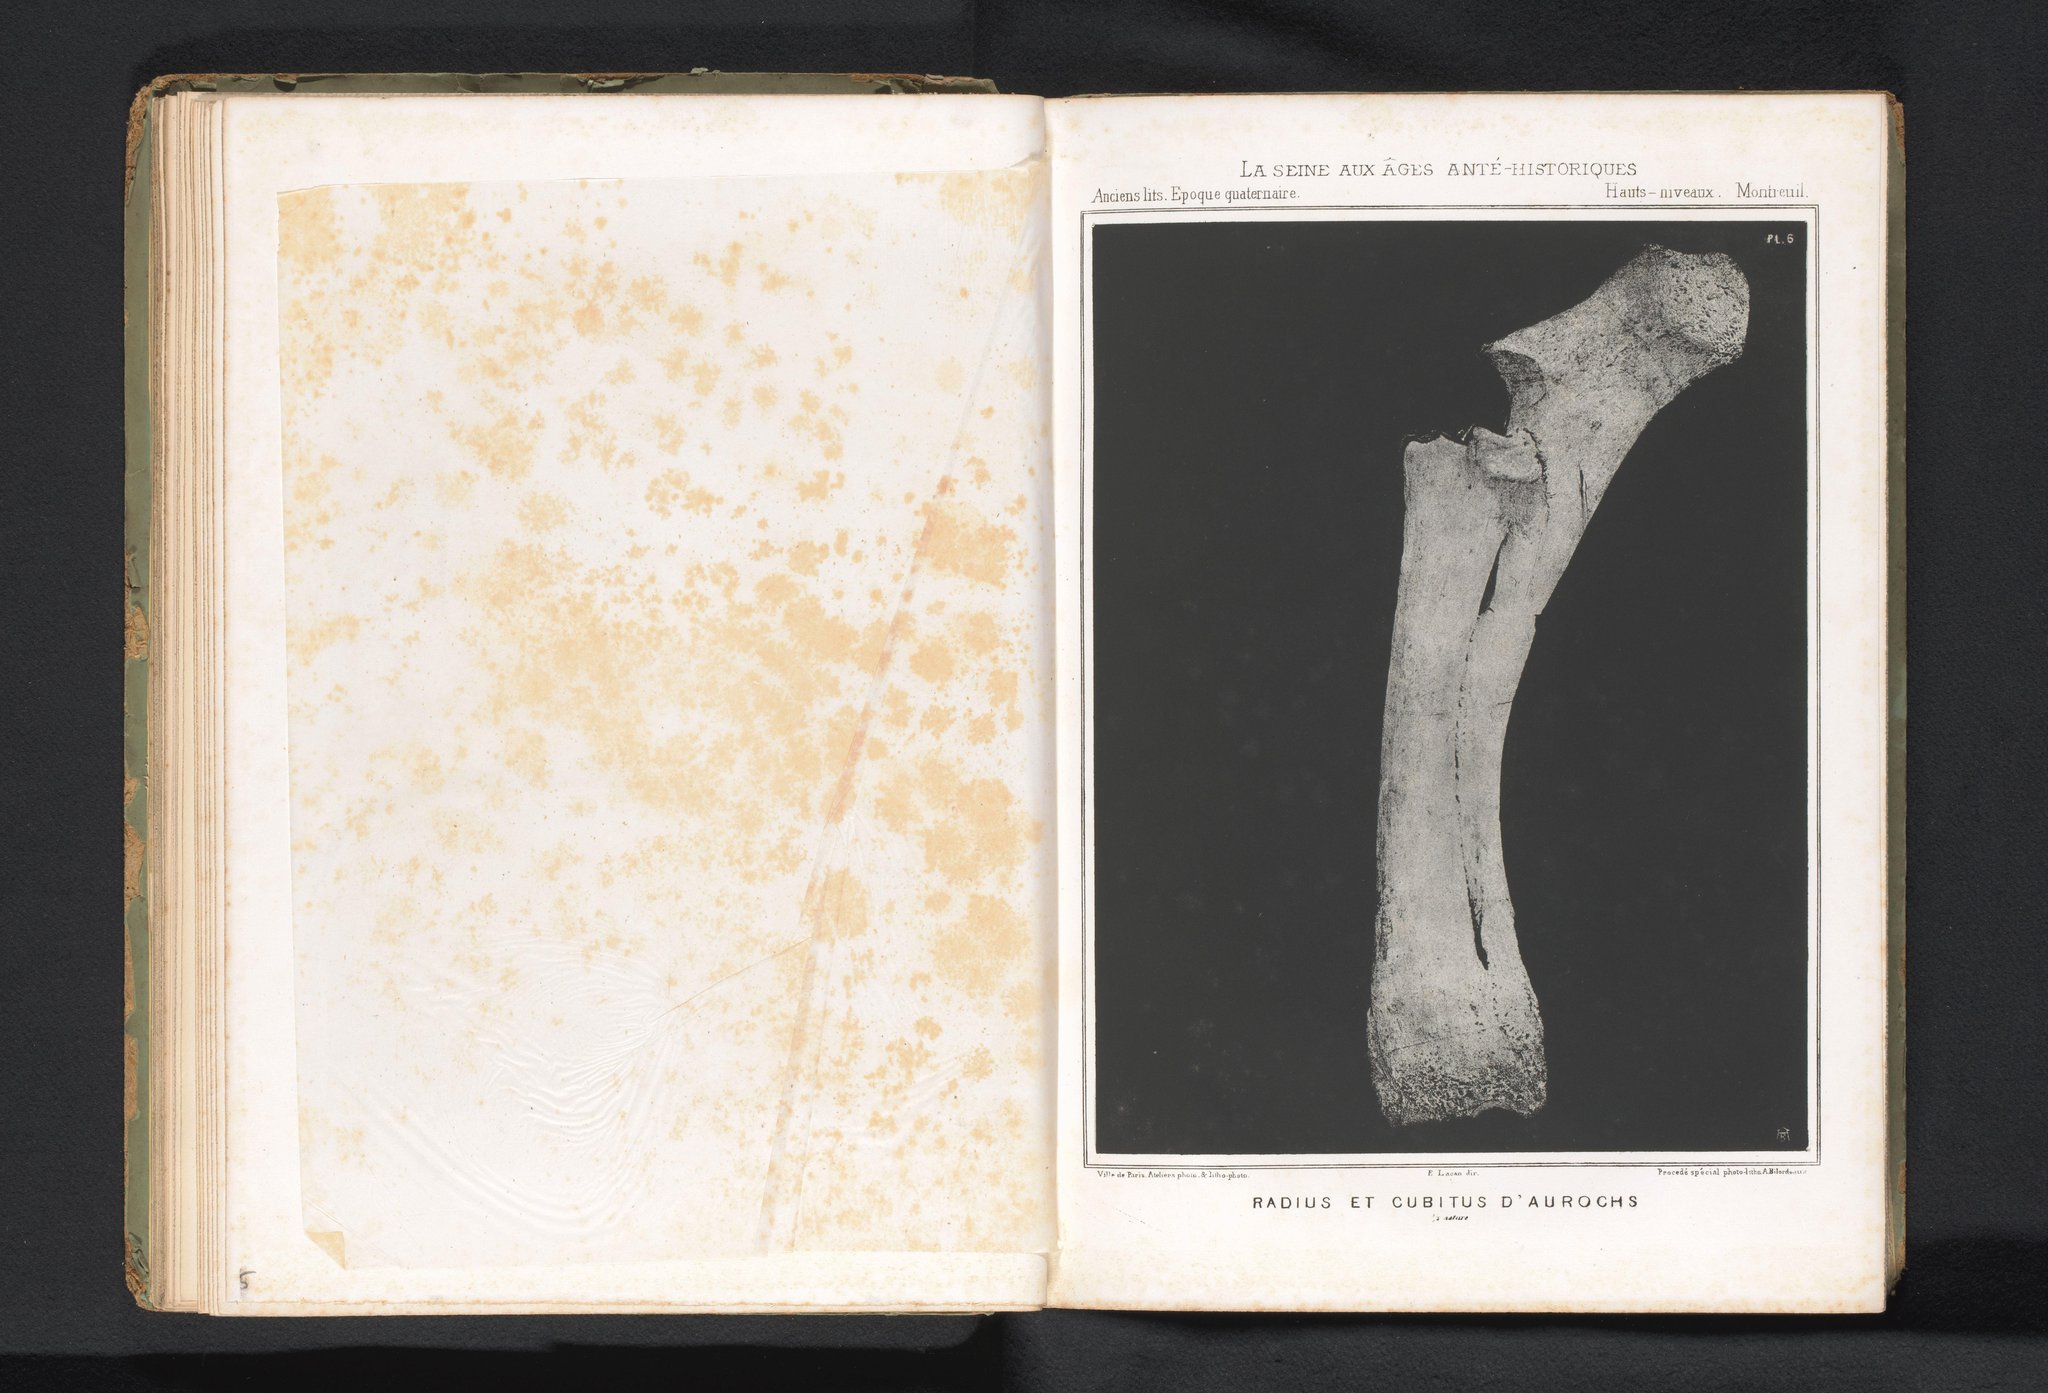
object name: photomechanical print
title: Ellepijp van een oeros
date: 1864-1869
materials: paper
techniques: photolithography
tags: animals (+ skeleton of an animal), palaeontology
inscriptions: number: ‘Pl. 6’, inscription: ‘Procedé spécial photo-litho. A. Bilordeaux’, monogram: ‘AB’, inscription: ‘1/2 nature’